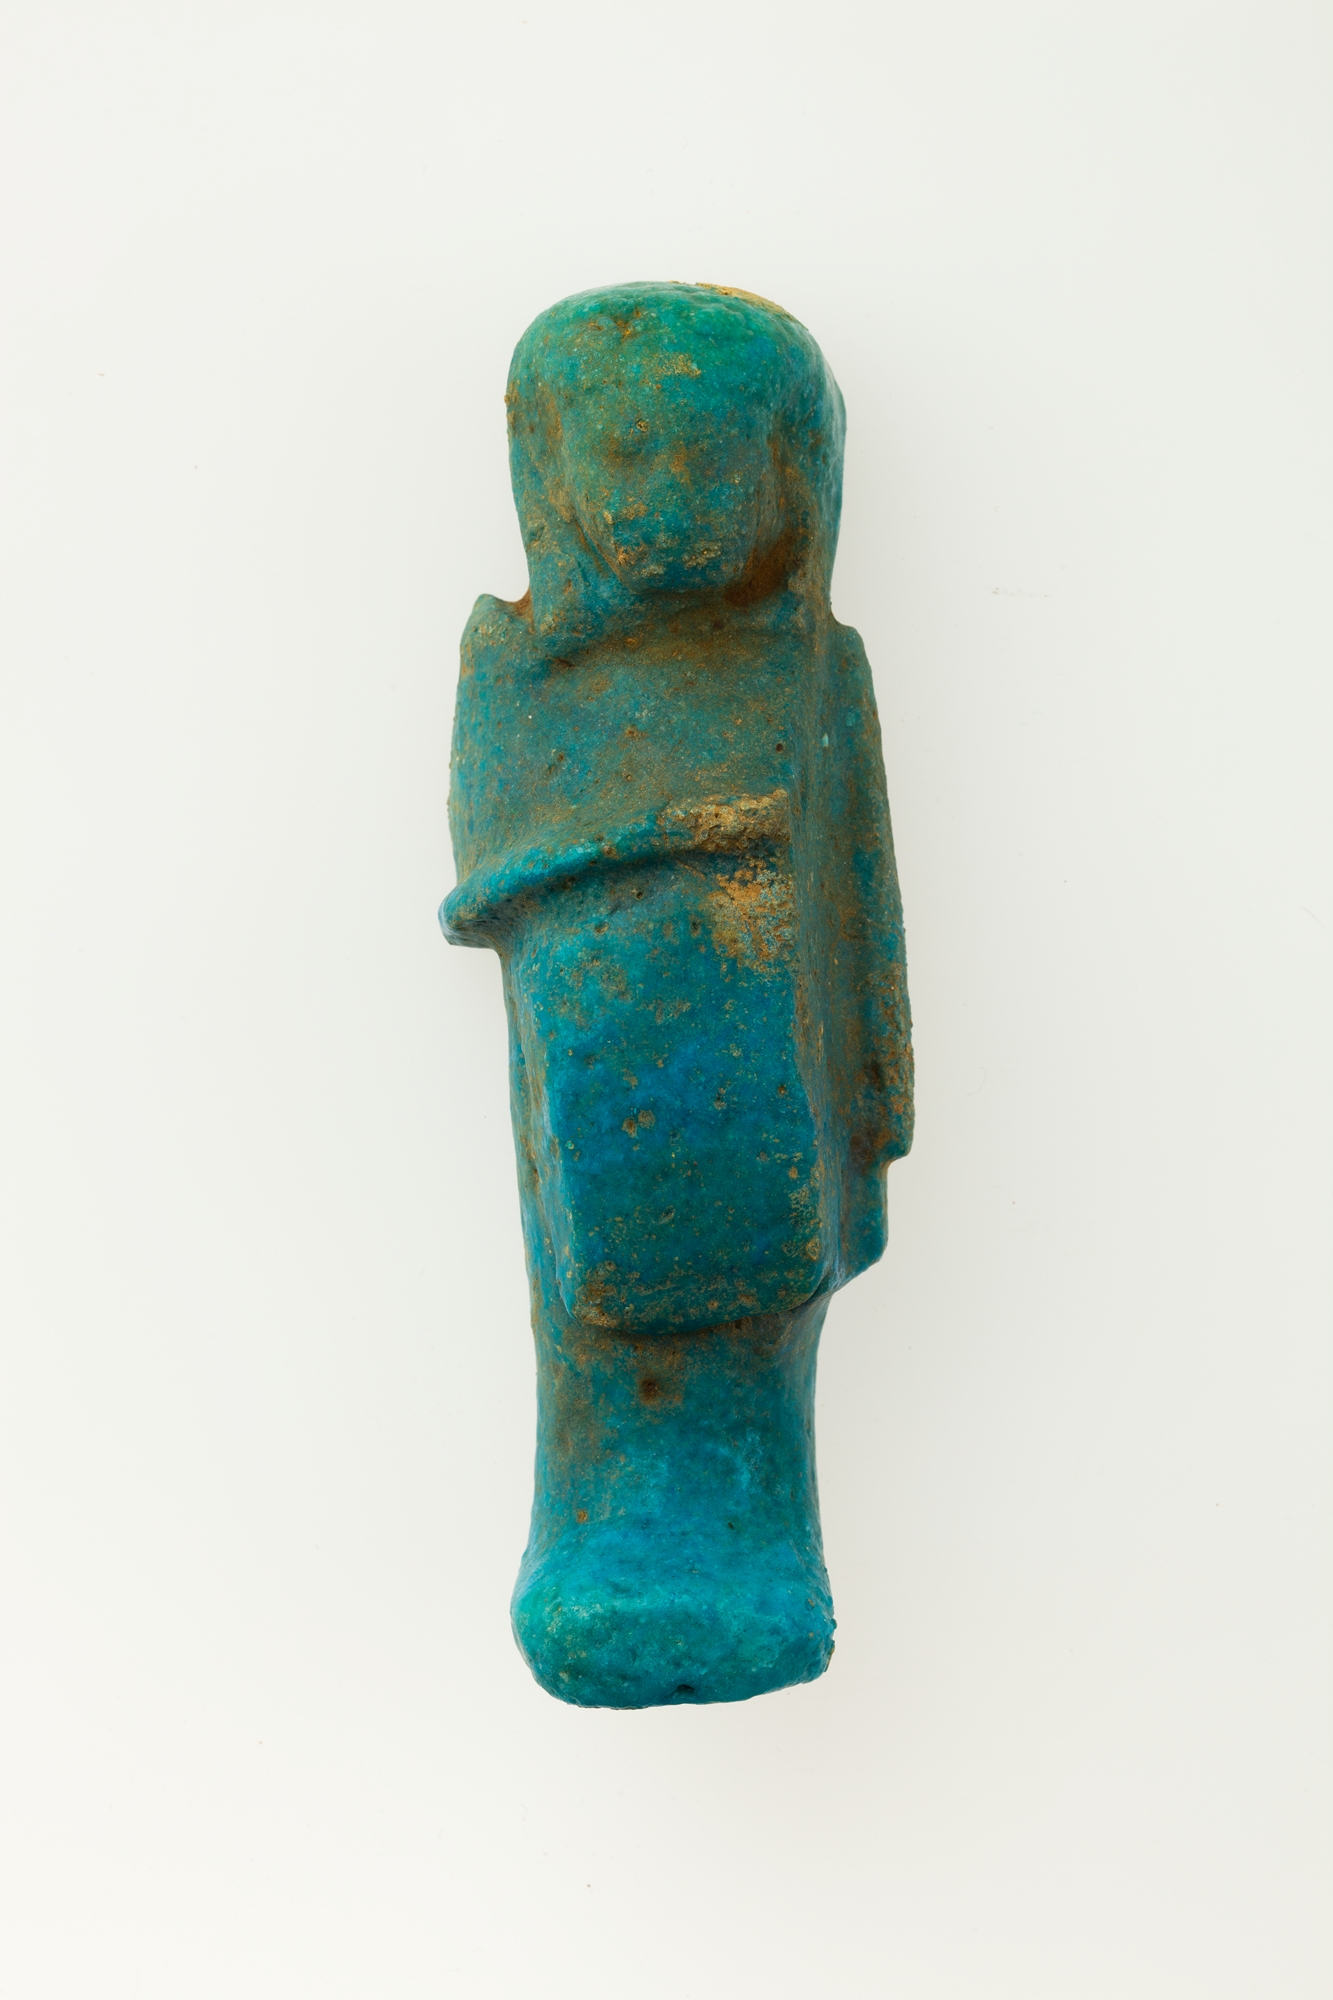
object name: shabti, henettawy c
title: Overseer Shabti of Henettawy (C), Daughter of Isetemkheb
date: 990-970 BCE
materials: faience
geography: egypt